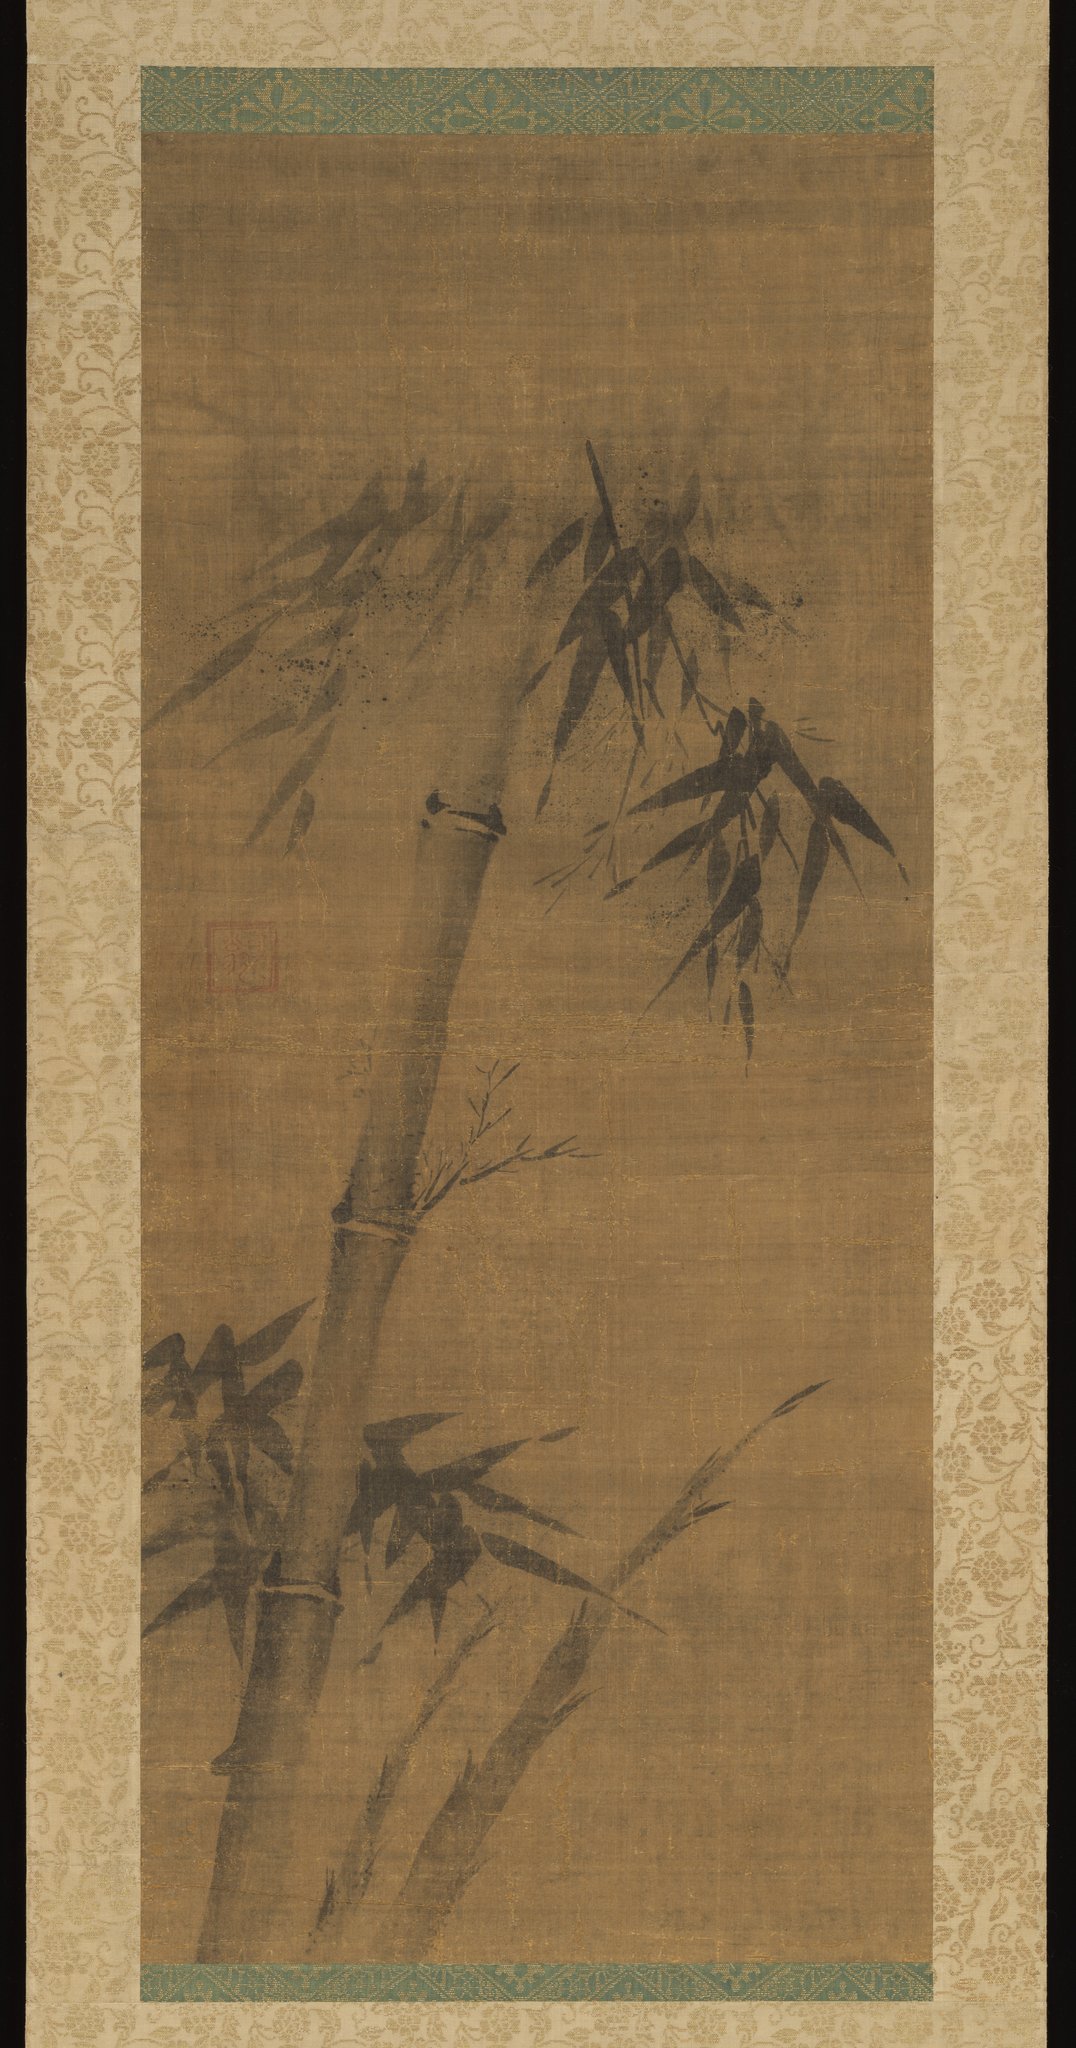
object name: hanging scroll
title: Bamboo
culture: japanese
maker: kaō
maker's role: artist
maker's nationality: japanese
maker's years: 1245-1345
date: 1501-1600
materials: ink, silk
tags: bamboo